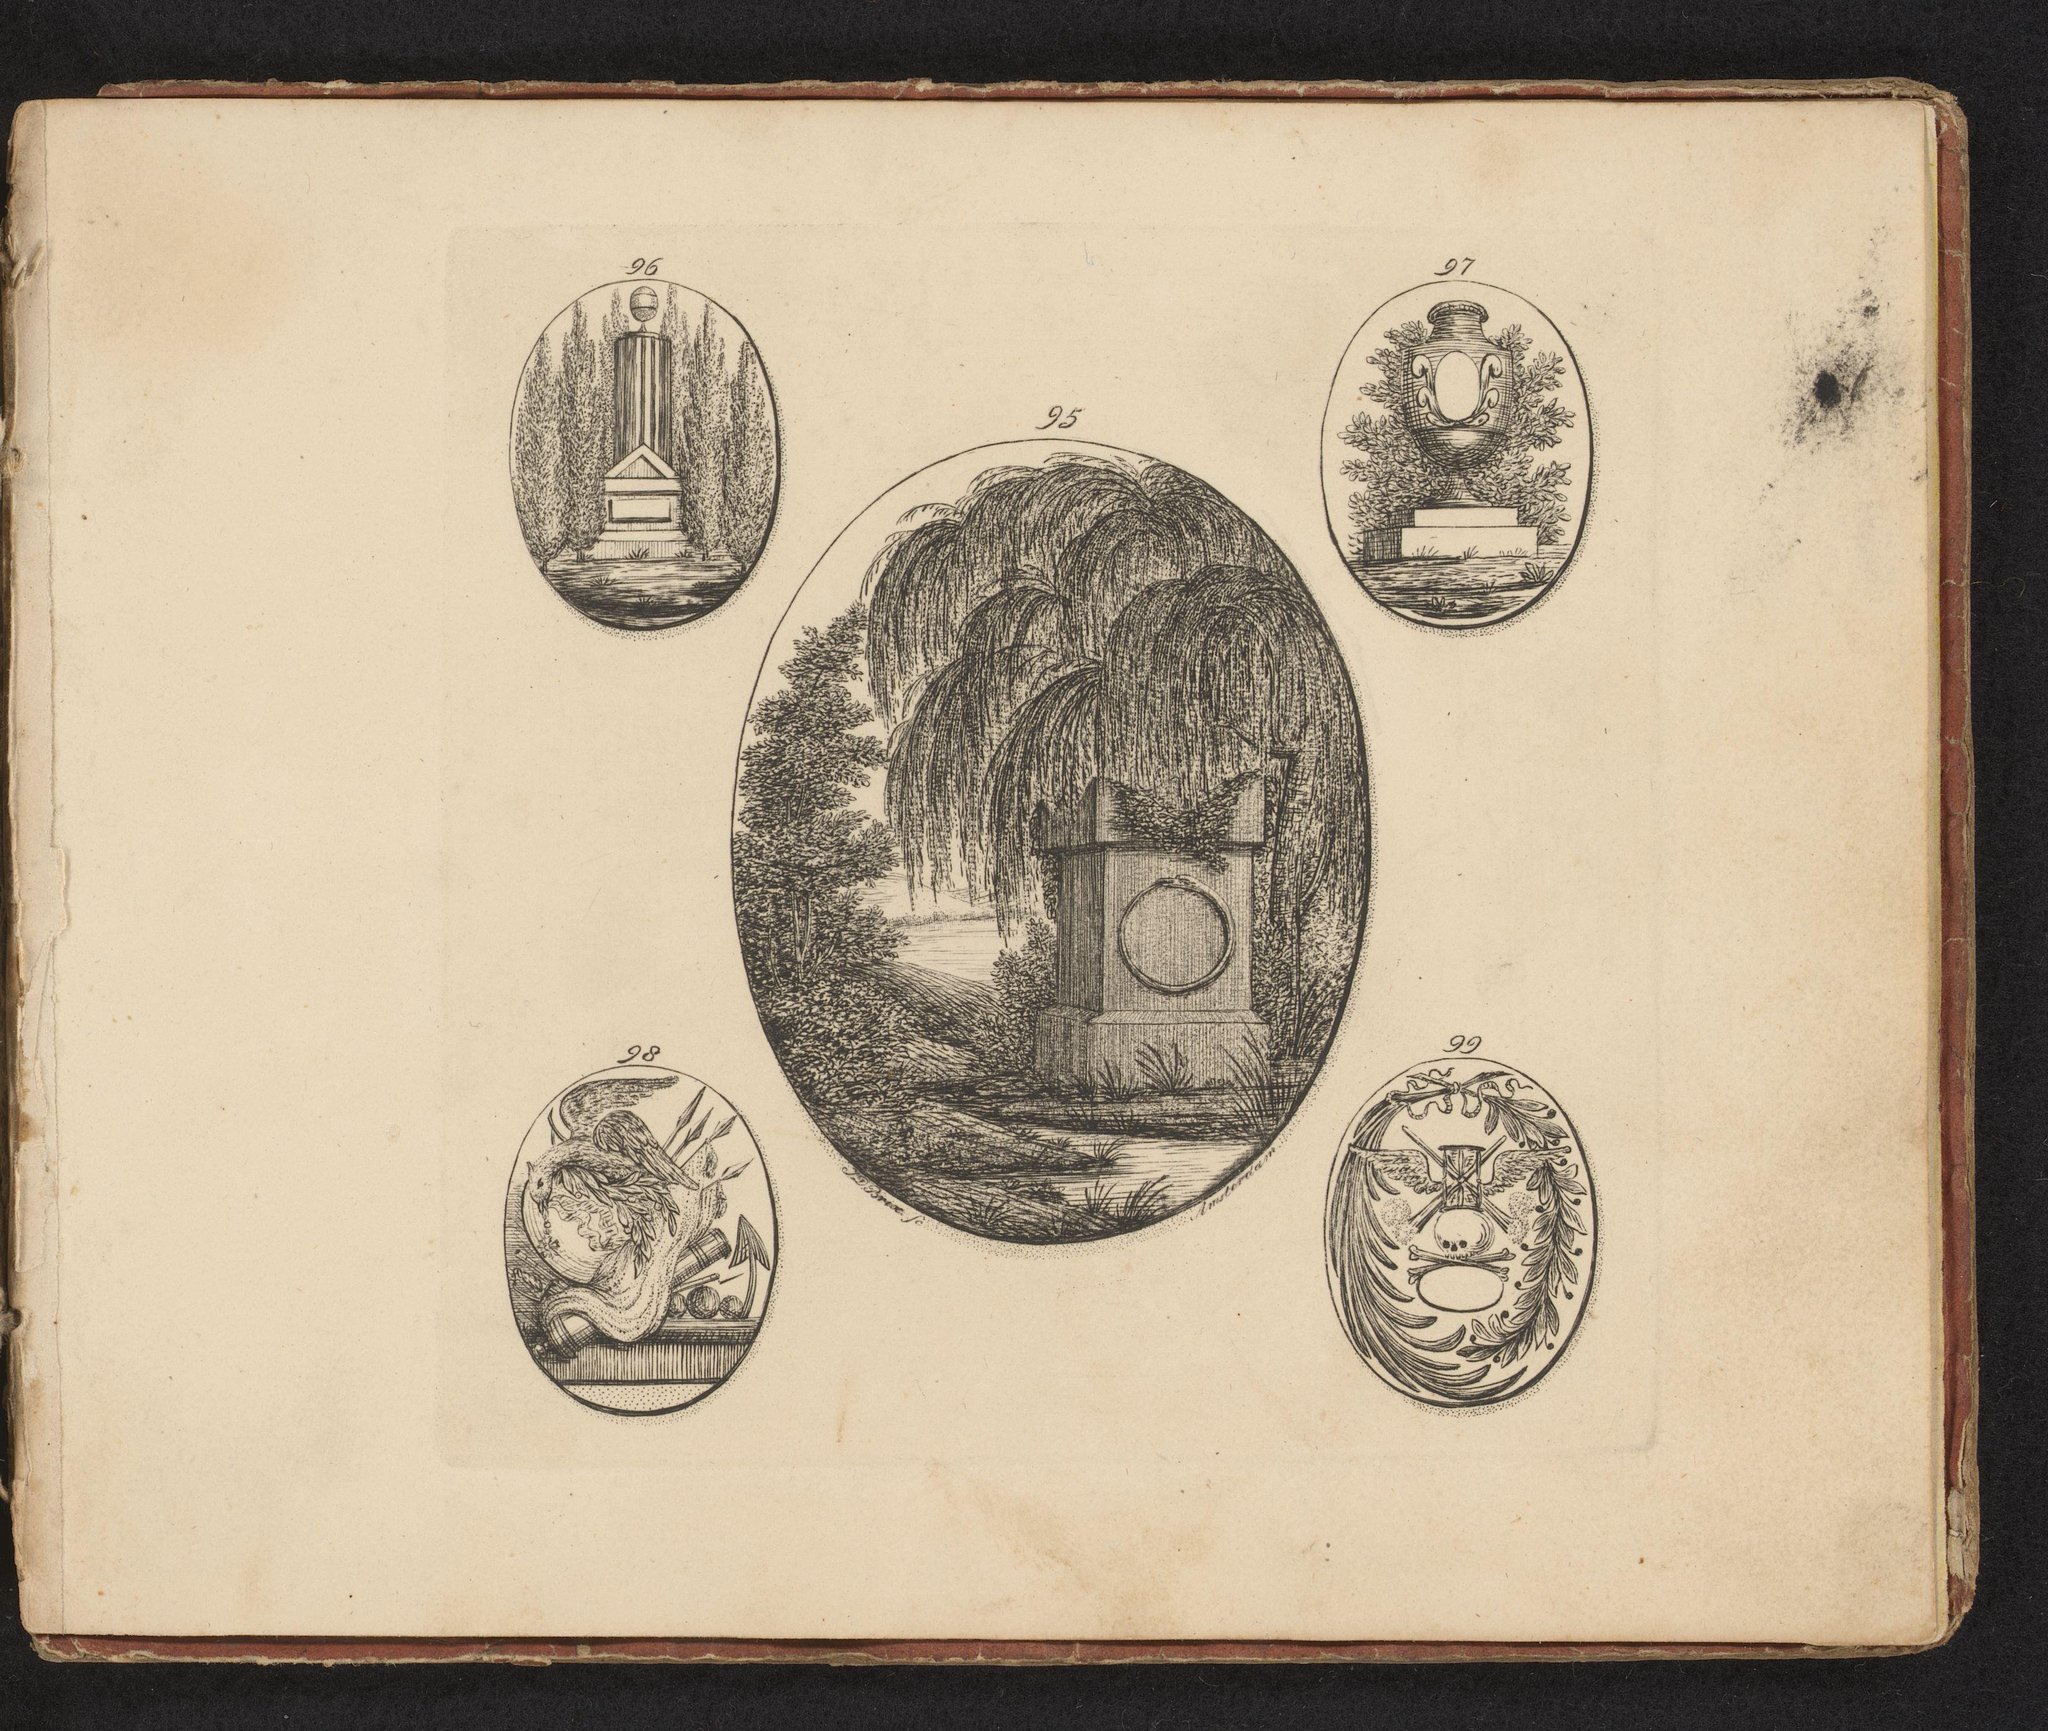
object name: album leaf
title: Vijf voorbeelden van rouwsieraden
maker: j.d. brix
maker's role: print maker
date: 1800-1810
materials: paper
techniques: etching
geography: amsterdam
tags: ornaments, jewels, mourning customs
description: Prent met daarop voorbeelden 95 tot en met 99 van sieraden ter herinnering aan een overledene. Deze prent maakt deel uit van een album.